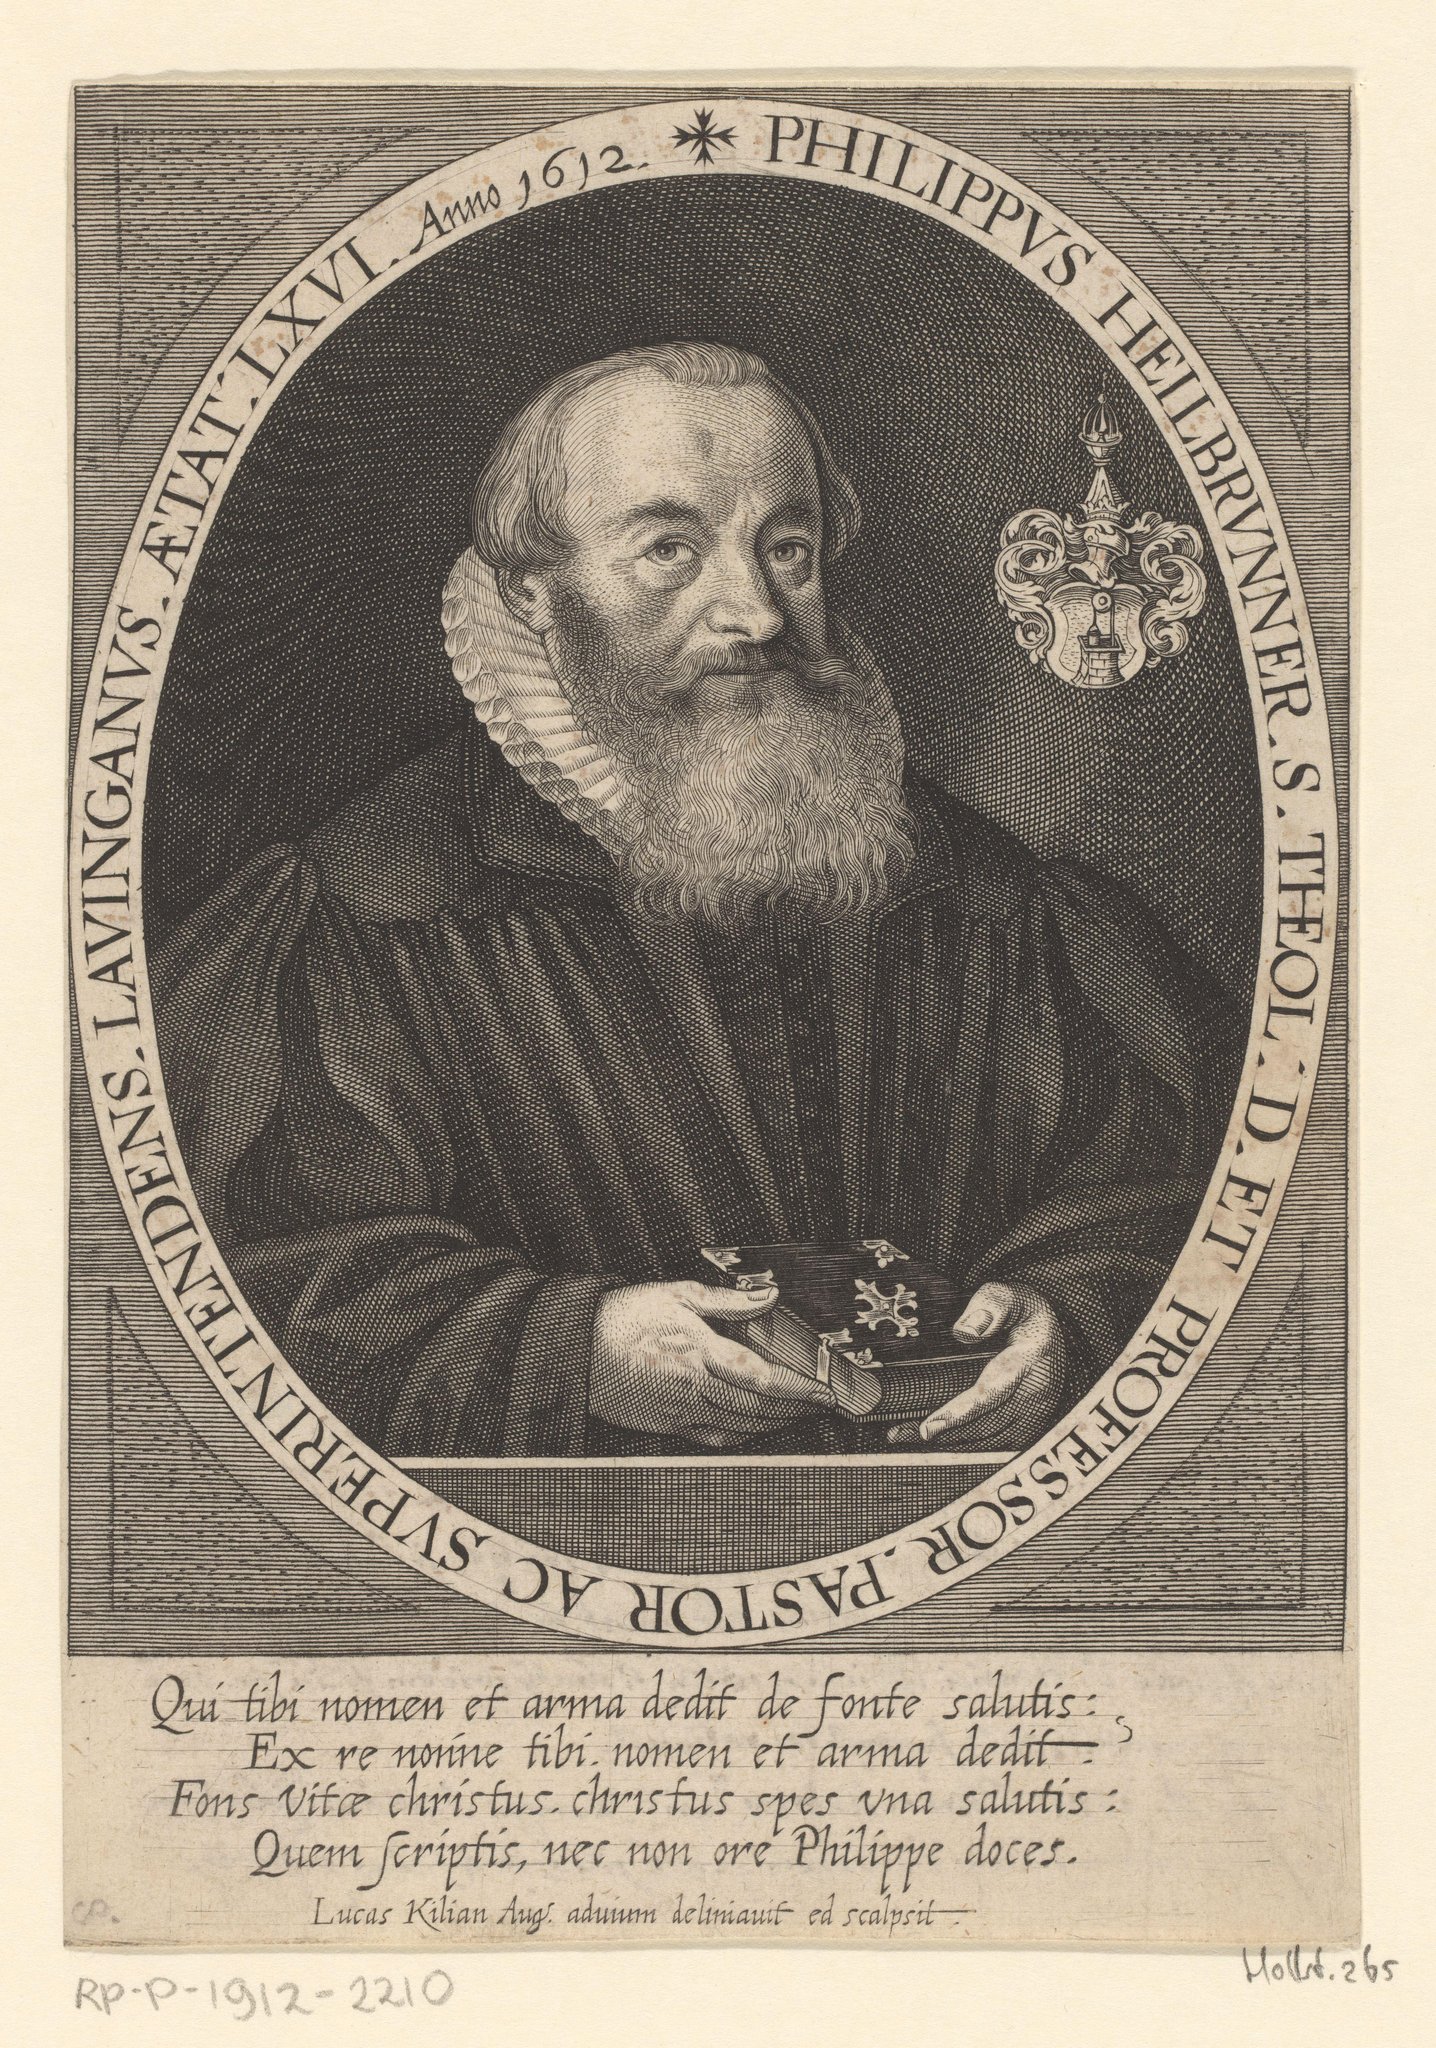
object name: print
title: Portret van Philipp Heilbrunner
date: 1612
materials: paper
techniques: engraving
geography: augsburg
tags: theologian, historical persons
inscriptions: collector's mark: Lugt 2228, annotation: ‘Natus (...) peperit.’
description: Tekst in het Latijn in de omlijsting en in de ondermarge.